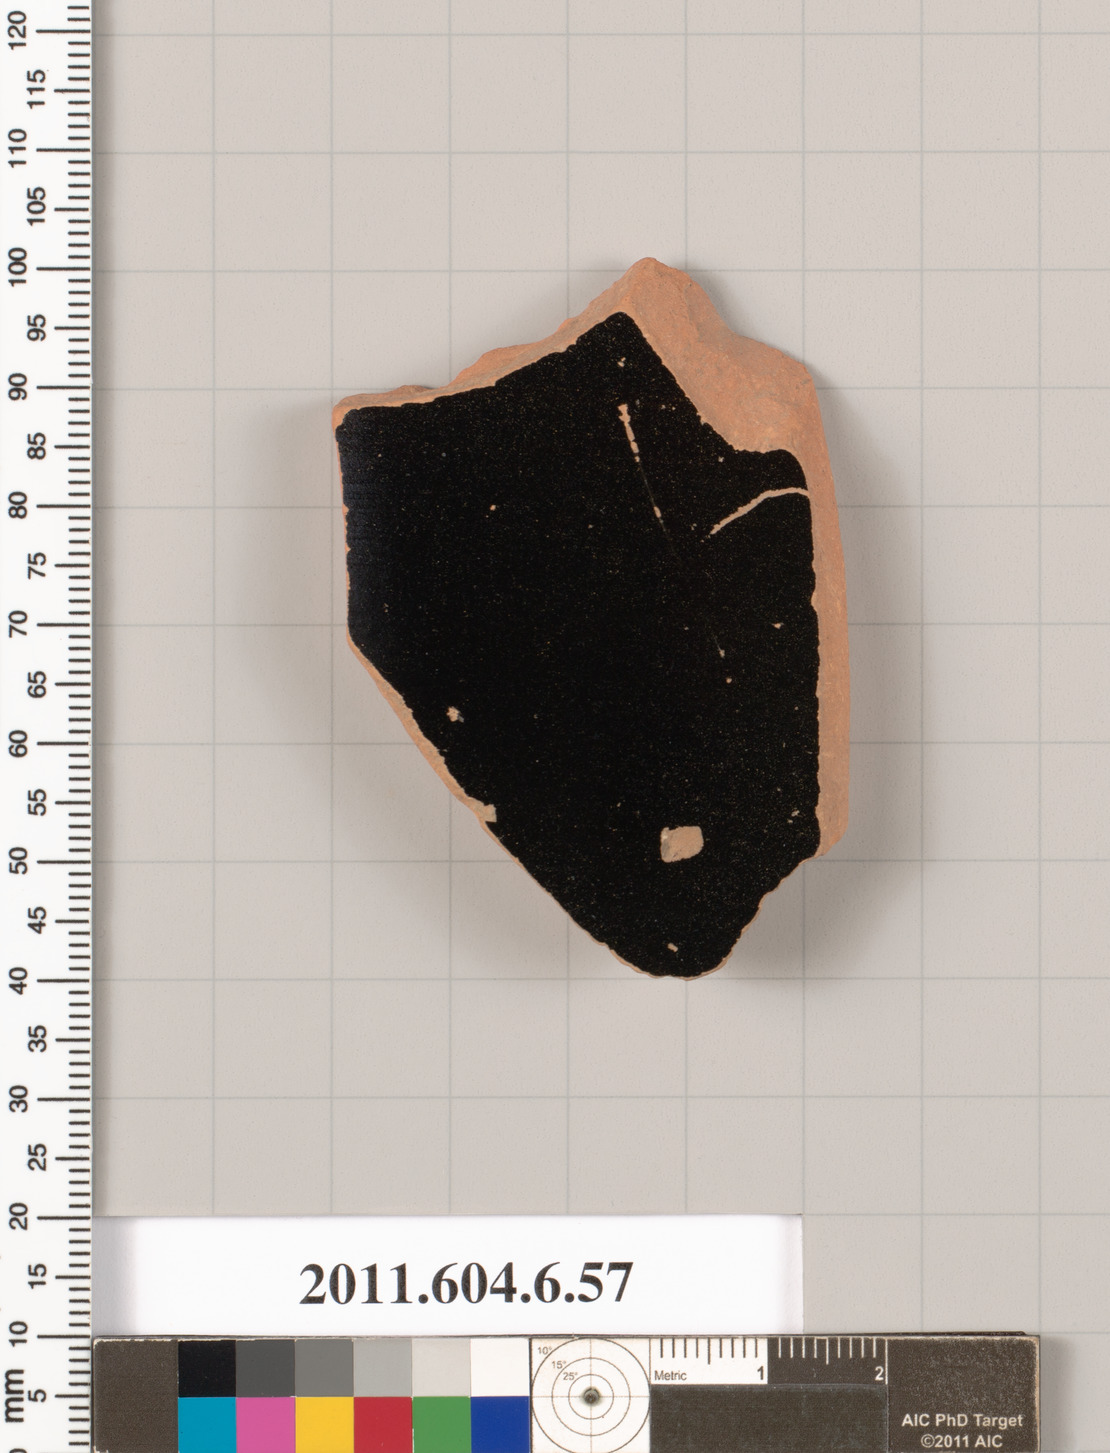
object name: amphora fragment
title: Terracotta fragment of an amphora (jar)?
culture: greek, attic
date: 600-401 BCE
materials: terracotta